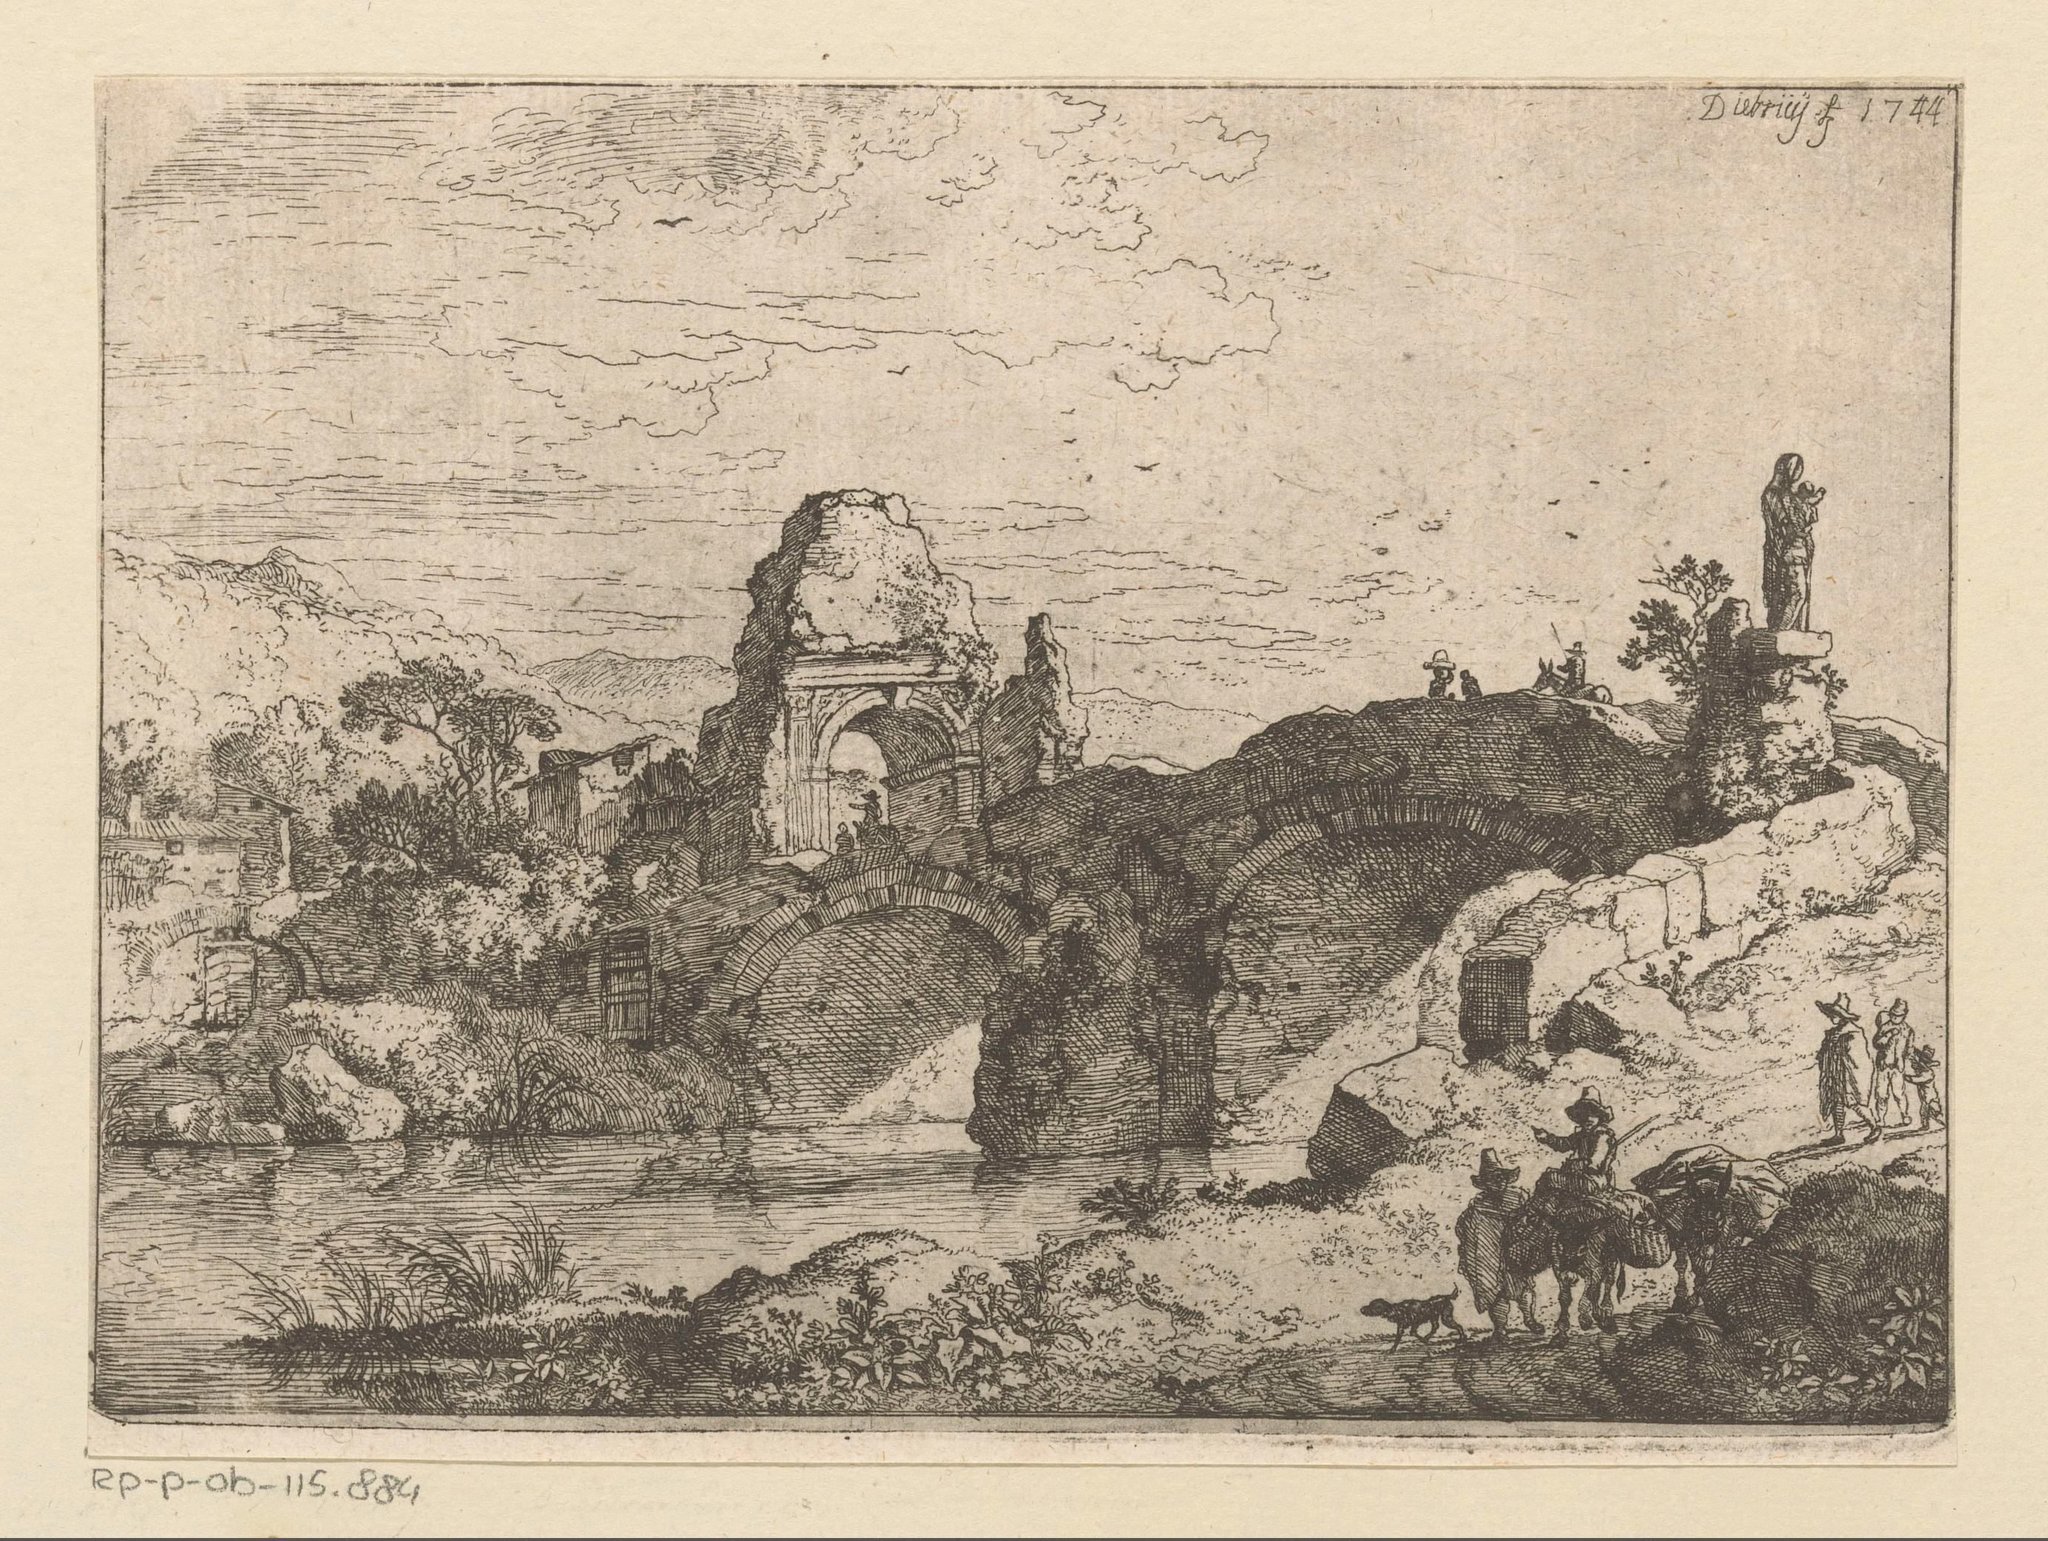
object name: print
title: Landschap met de ruïne van een poort naast een vervallen brug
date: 1744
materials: paper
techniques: etching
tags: madonna: i.e. mary with the christ-child, river, landscape with ruins, monument, statue, mountains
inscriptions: collector's mark: Lugt 240